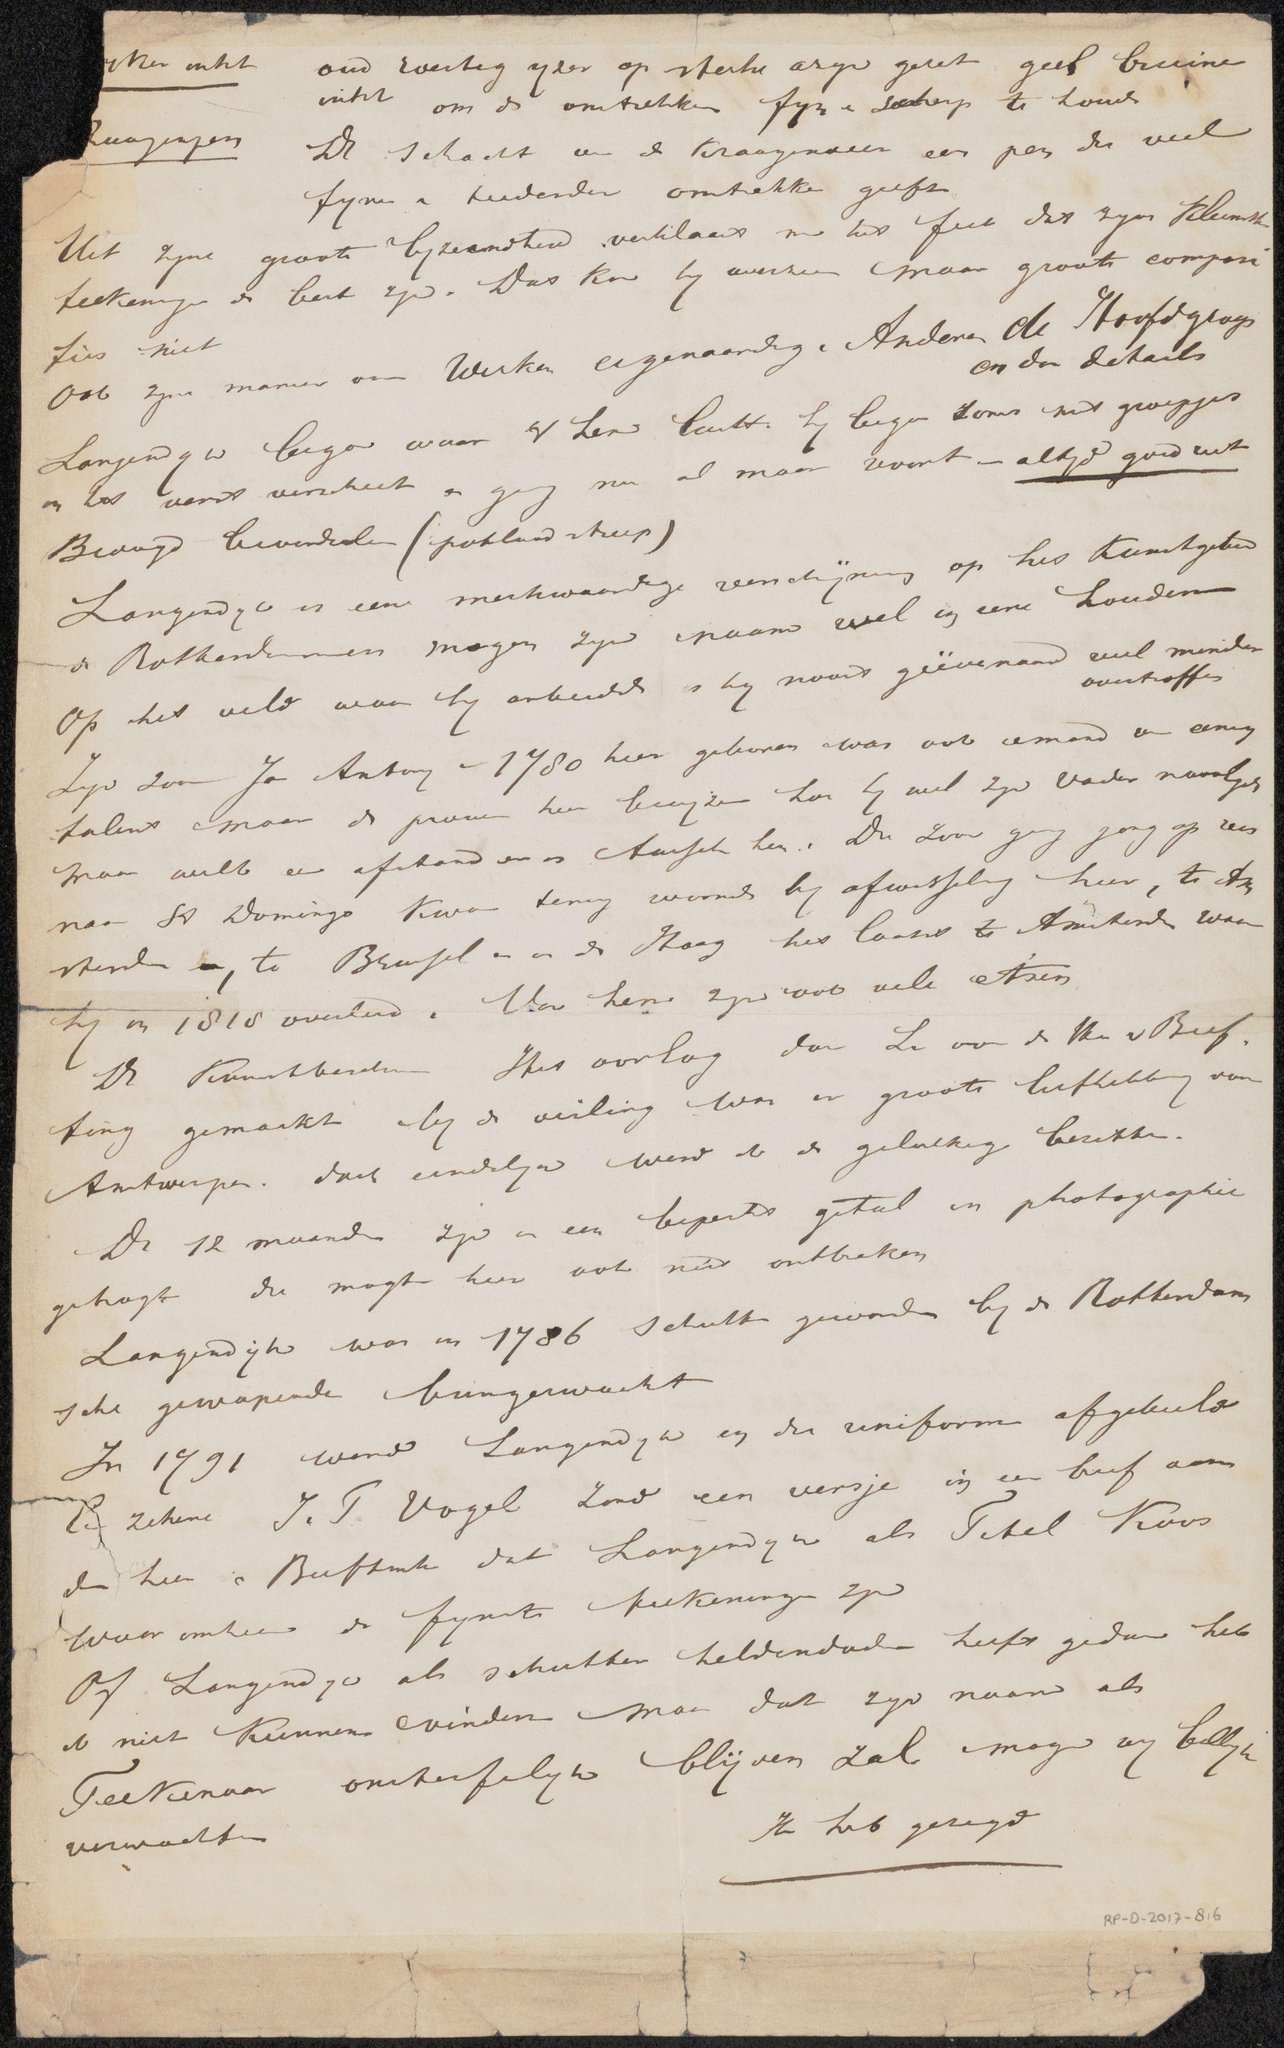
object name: tekst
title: Tekst betreffende Dirk Langendijk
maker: Anonymous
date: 1850-1919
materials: ink, paper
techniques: pen, writing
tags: rotterdam, print maker, draughtsman, dirk langendijk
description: De tekst is mogelijk verzonden in envelop RP-D-2017-810.